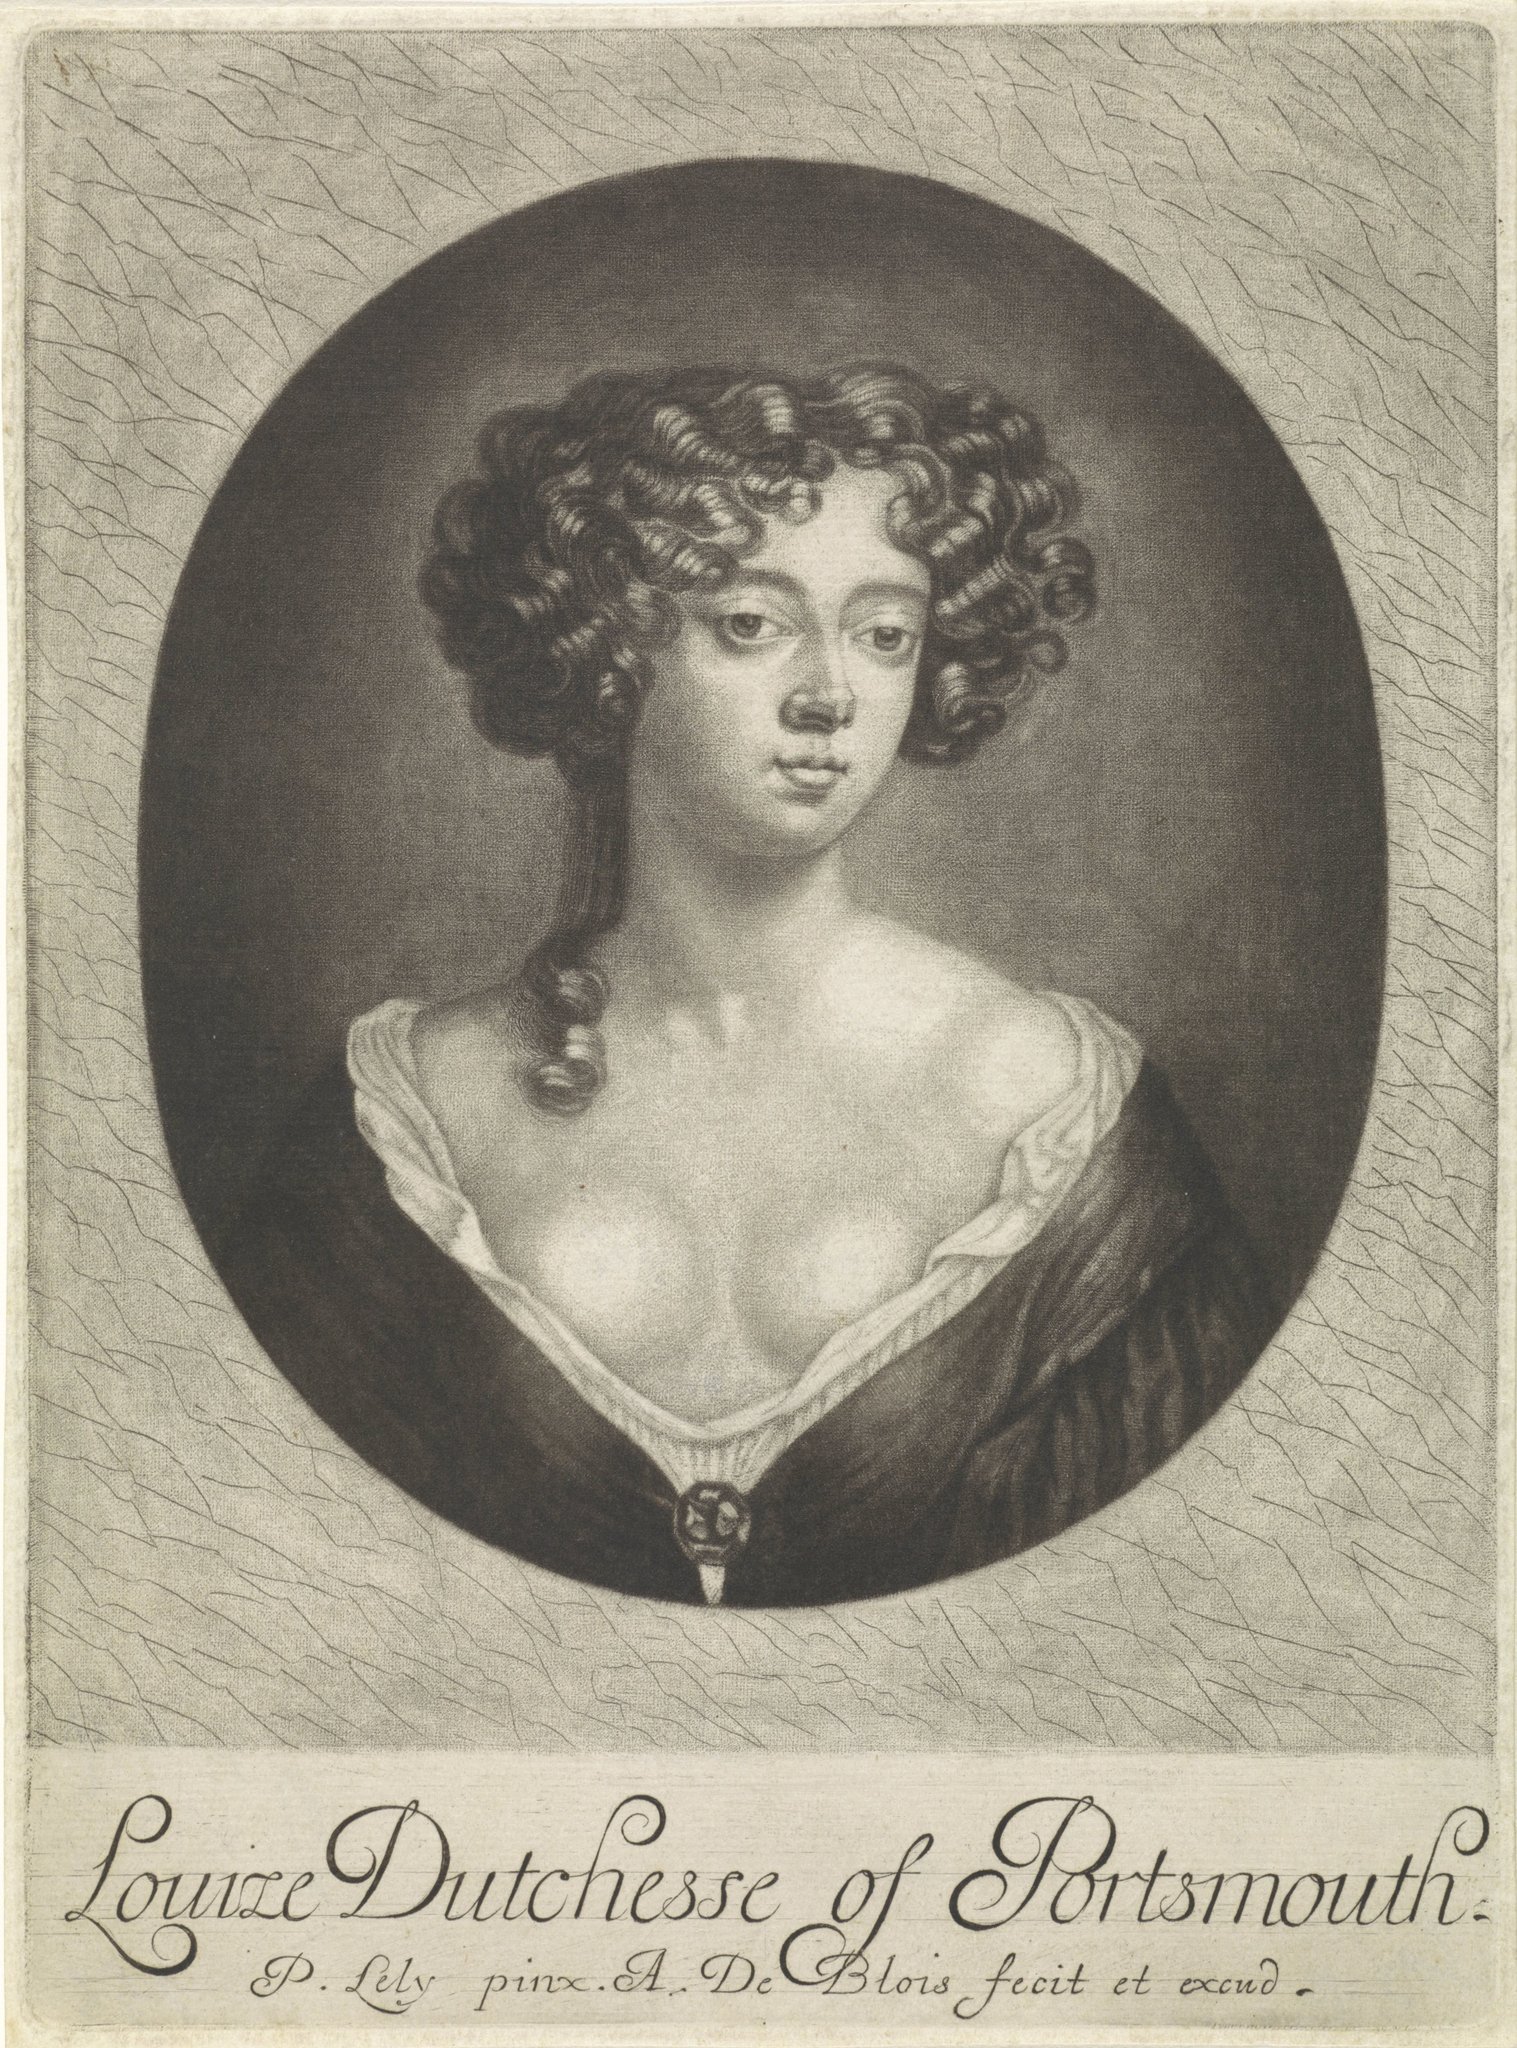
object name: print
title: Portret van Louise de Kéroualle hertogin van Portsmouth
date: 1679-1709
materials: paper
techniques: engraving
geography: netherlands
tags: hofdame, louise de kéroualle hertogin van portsmouth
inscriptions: collector's mark: Lugt 2228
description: Portret van Louise de Kéroualle hertogin van Portsmouth. Ze was een van de maîtresses van Karel II van Engeland en werd in 1673 tot hertogin verheven.